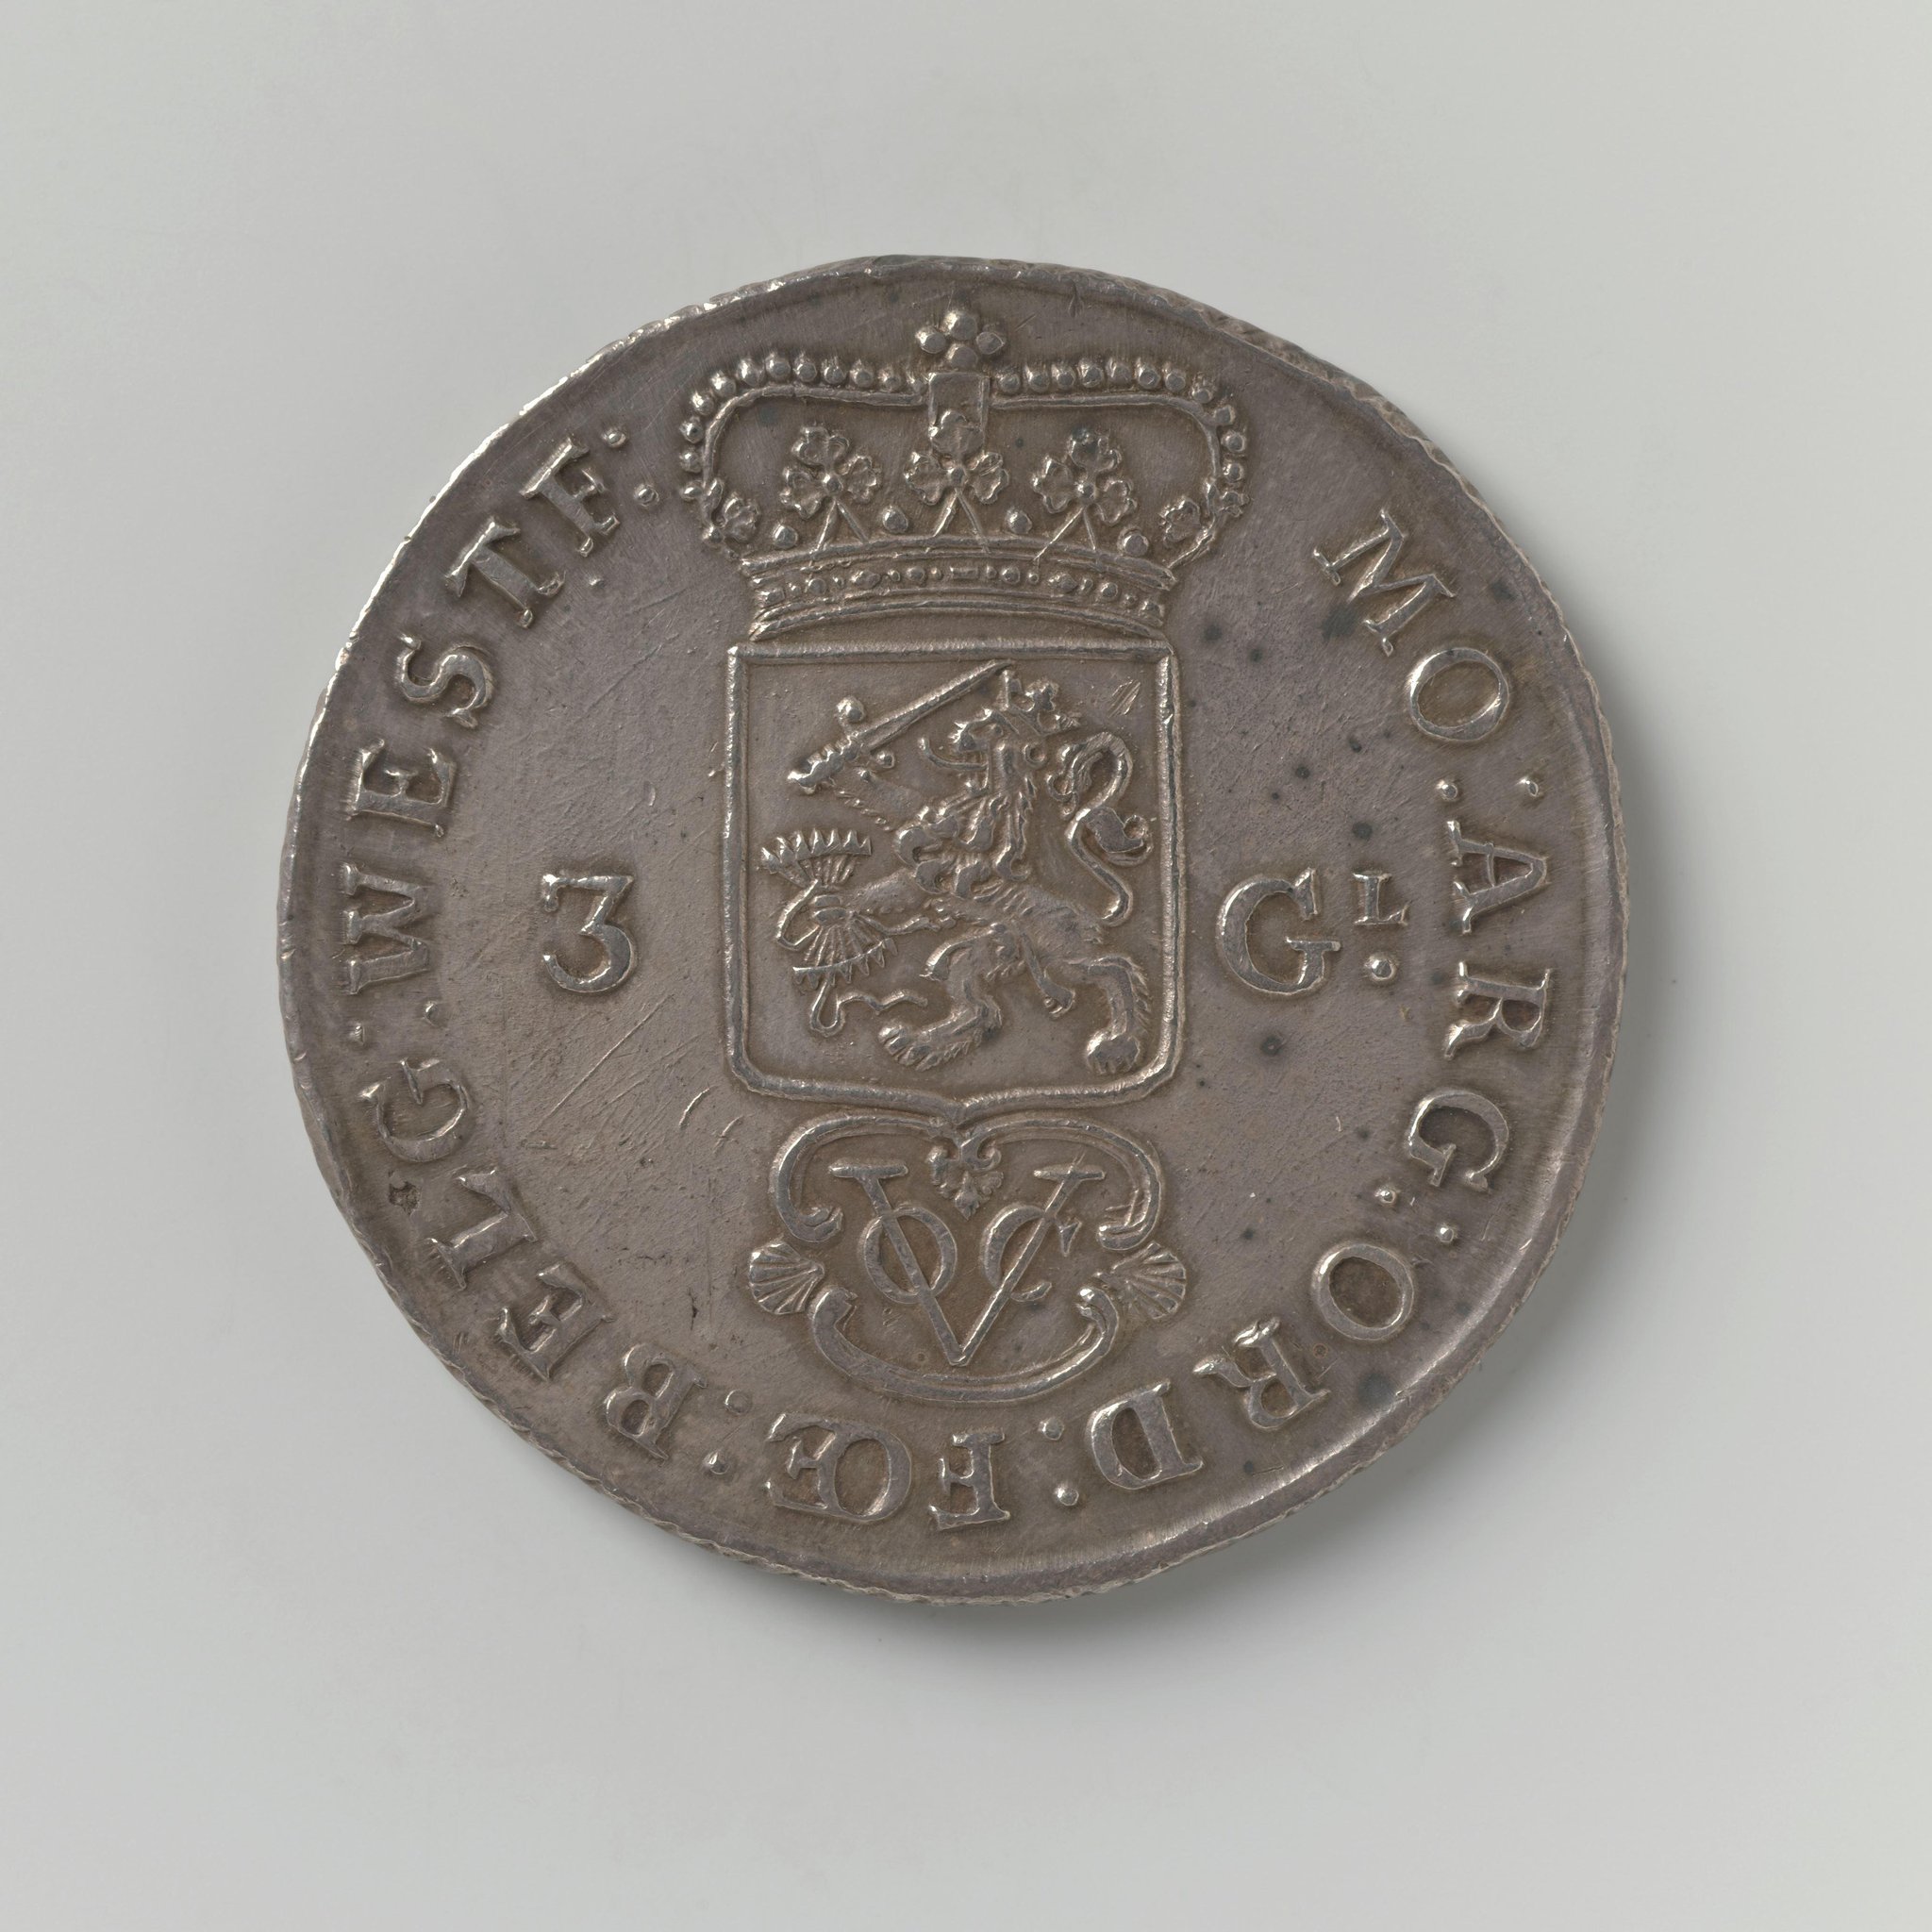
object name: coin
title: VOC, drie gulden, Westfriesland,1786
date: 1786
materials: silver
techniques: striking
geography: hoorn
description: Zilveren munt. Voorzijde: tussen waarde-aanduiding 3 Gl. gekroond generaliteitswapenschild, waaronder cartouche, waarin monogram van de VOC. Keerzijde: Nederlandse maagd met speer, waarop vrijheidshoed, leunend op een bijbel op een altaar. Jaartal in afsnede. Kabelrand.